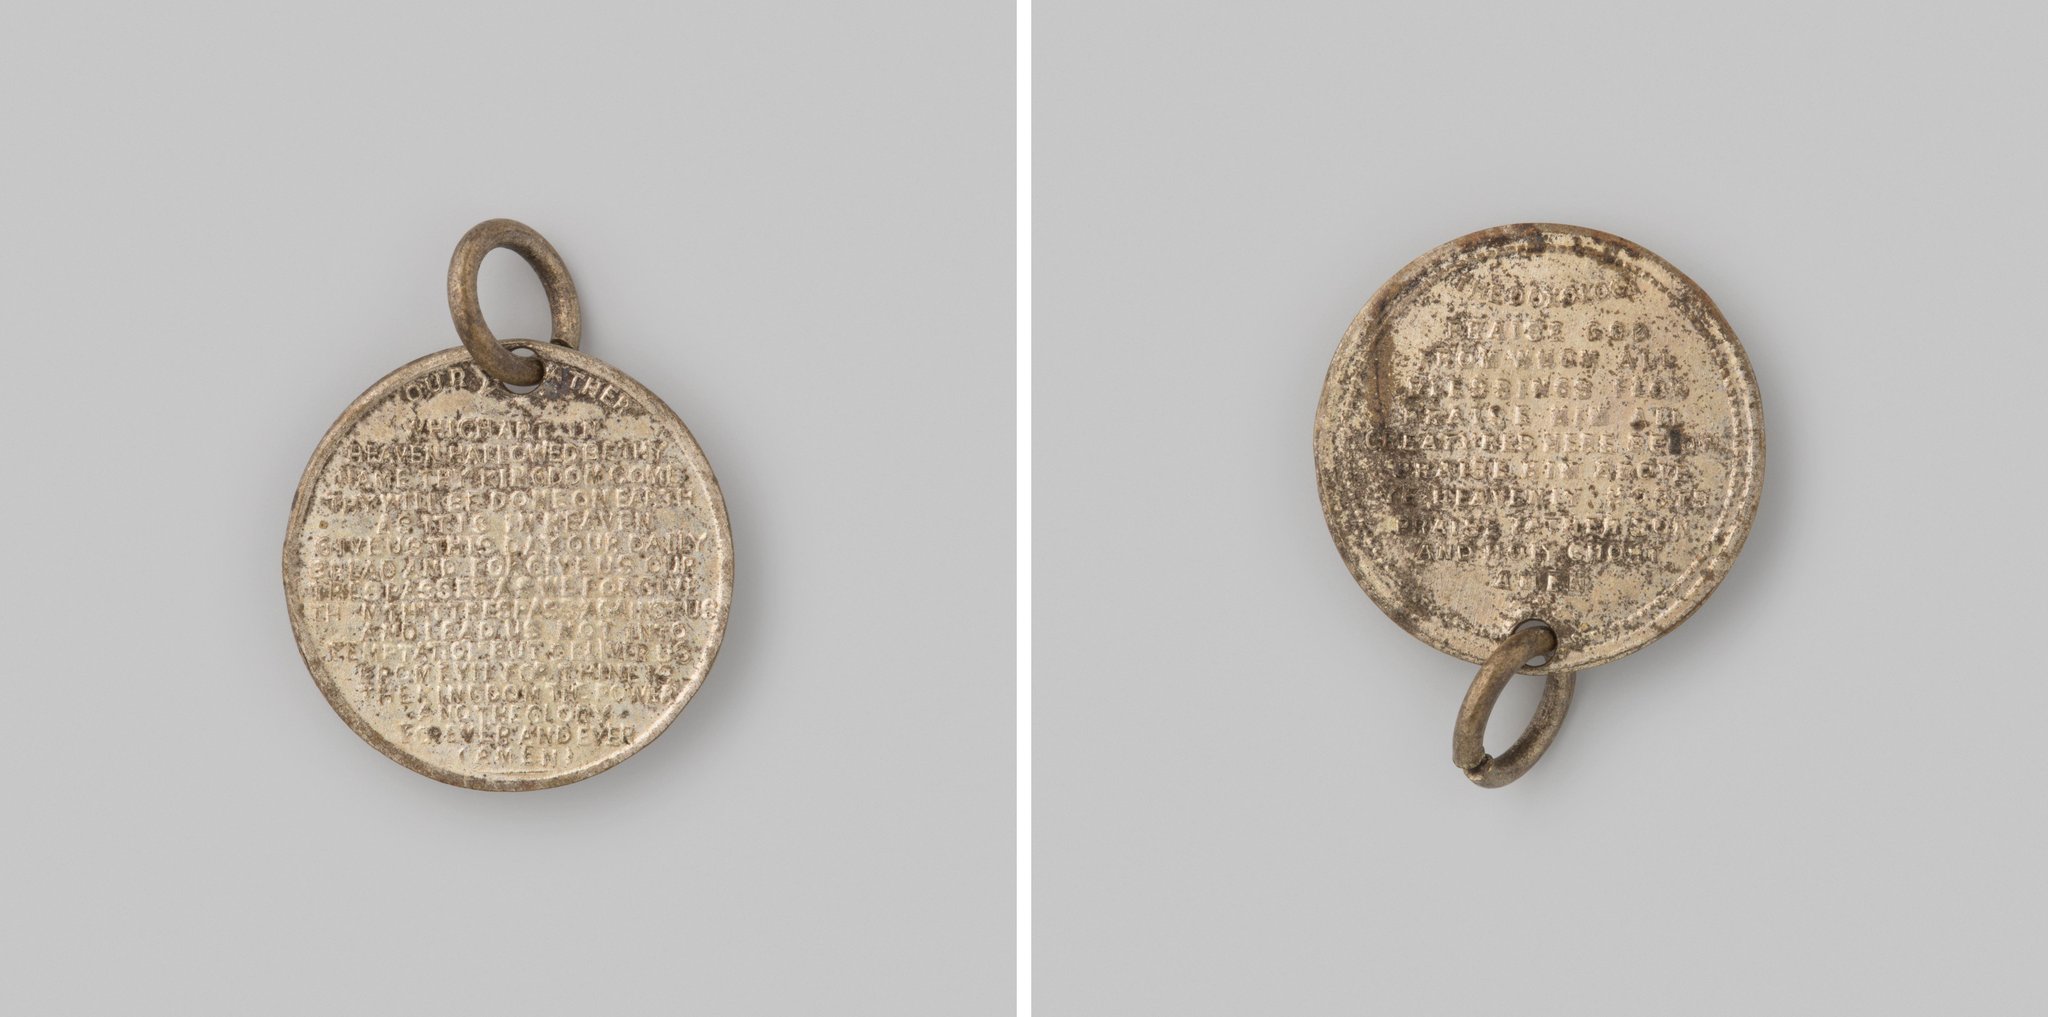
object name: history medal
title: Engels religieus draagpenninkje met gebedsteksten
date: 1875-1900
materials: brass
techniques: silvering, striking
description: Zilverkleurige penning met doorboring en draagring, op de voorzijde zeventien regels tekst, op de keerzijde elf regels tekst.